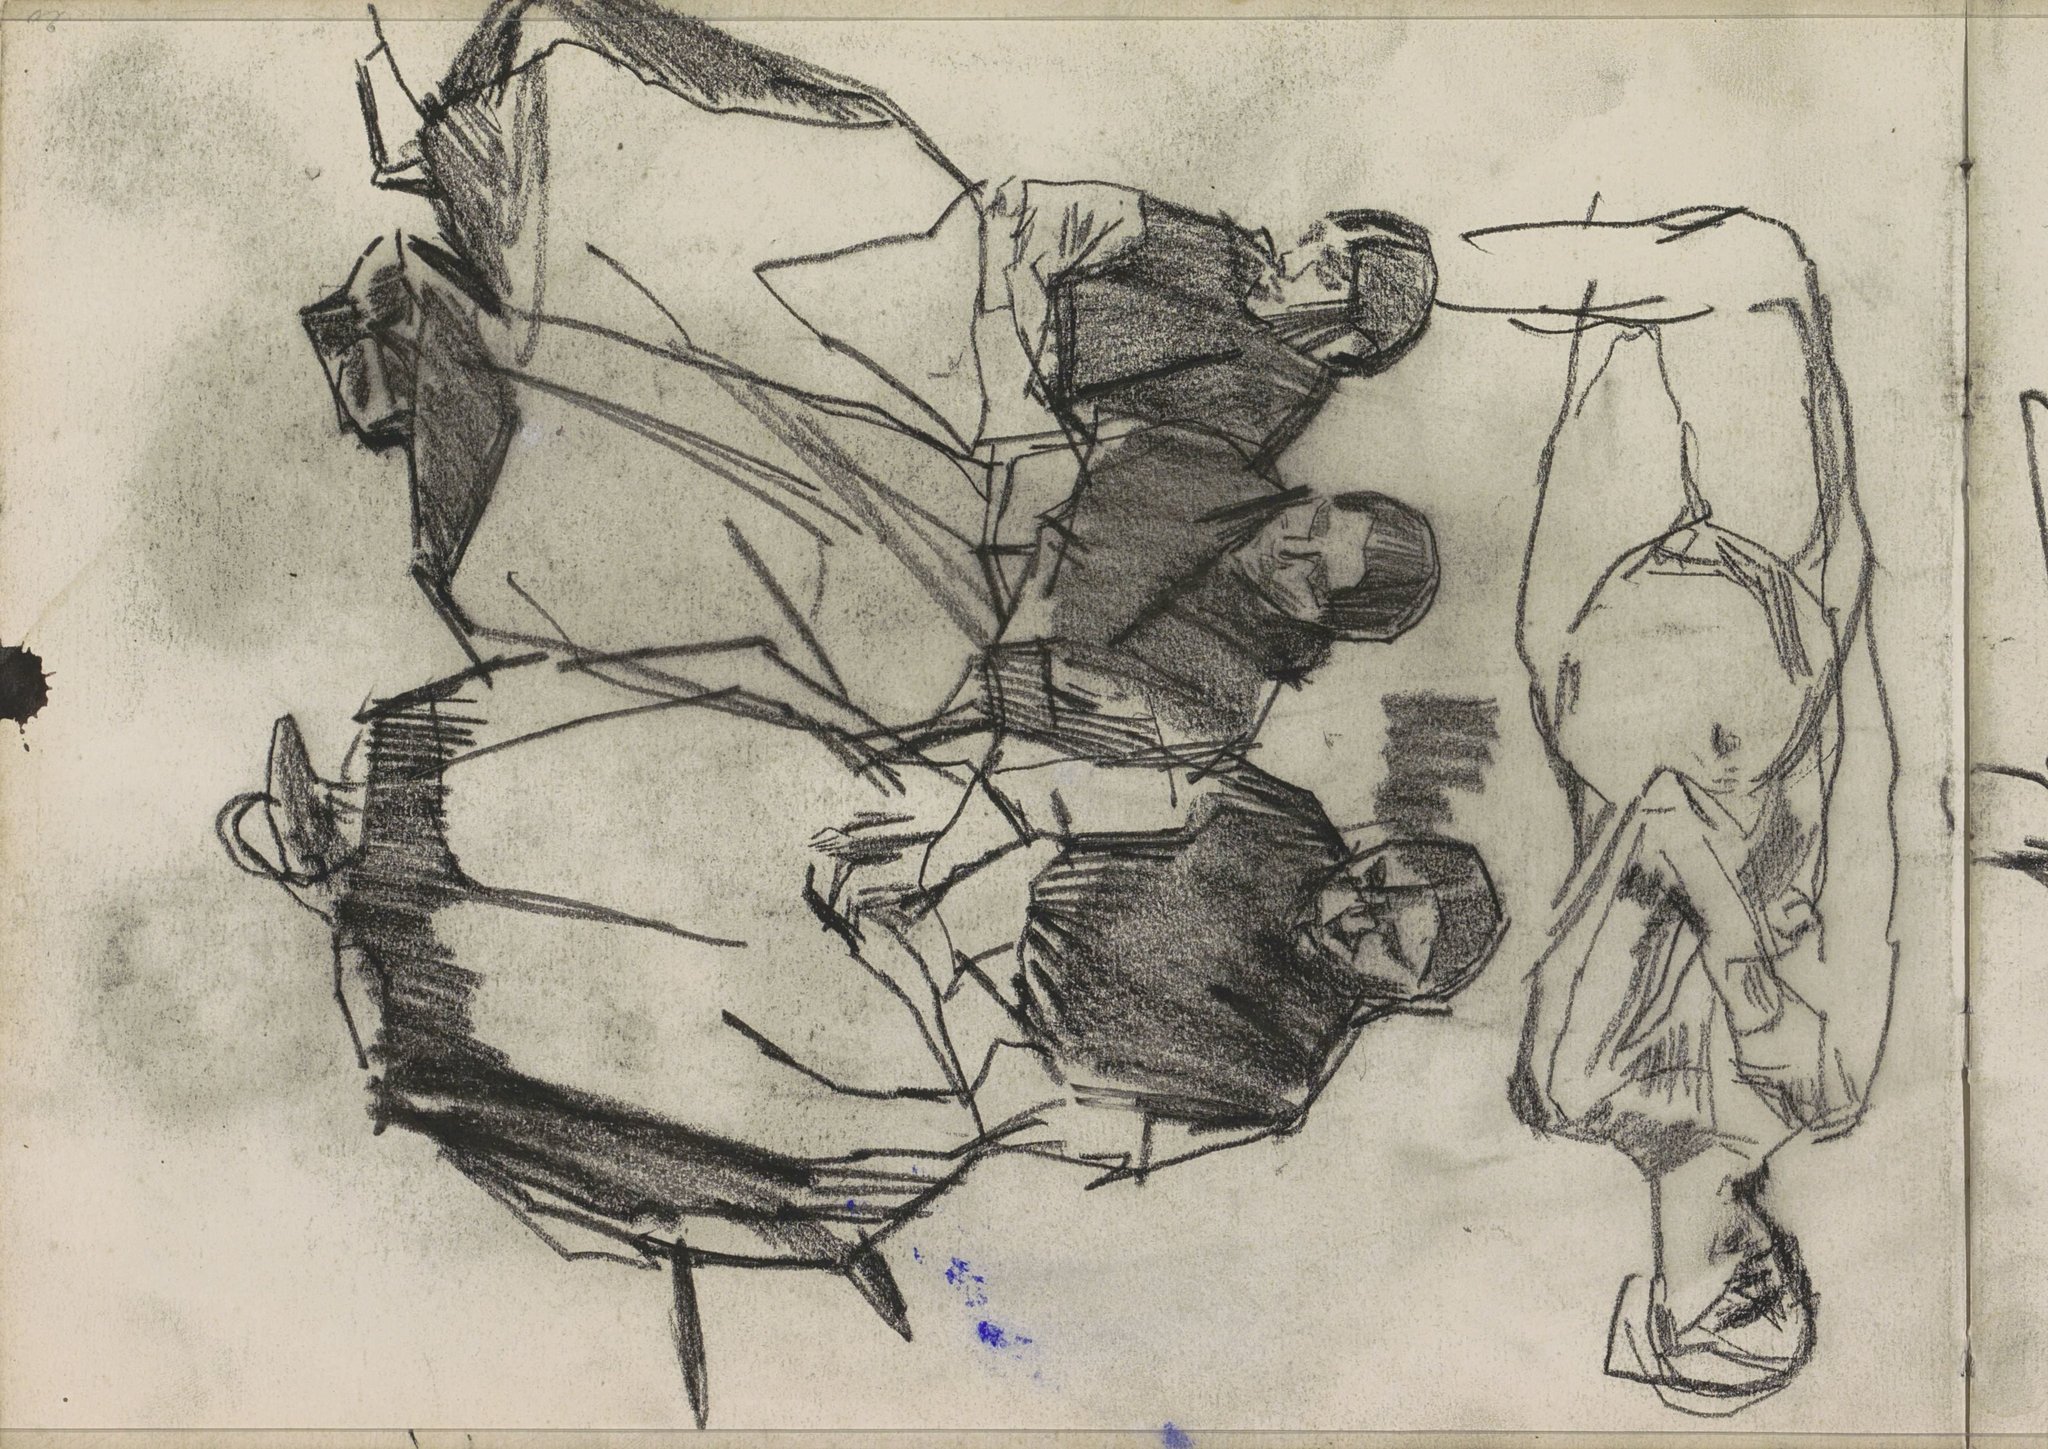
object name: sketchbook leaf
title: Drie zittende vrouwen en een vrouwelijk naakt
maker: isaac israels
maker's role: draughtsman, painter, print maker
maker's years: 1865-1934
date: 1892-1900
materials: chalk, paper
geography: the hague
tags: sitting figure - aa - female human figure, the (nude) human figure; 'corpo humano' (ripa) - aa - female human figure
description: Blad 5 verso uit schetsboek VIII met 12 bladen.